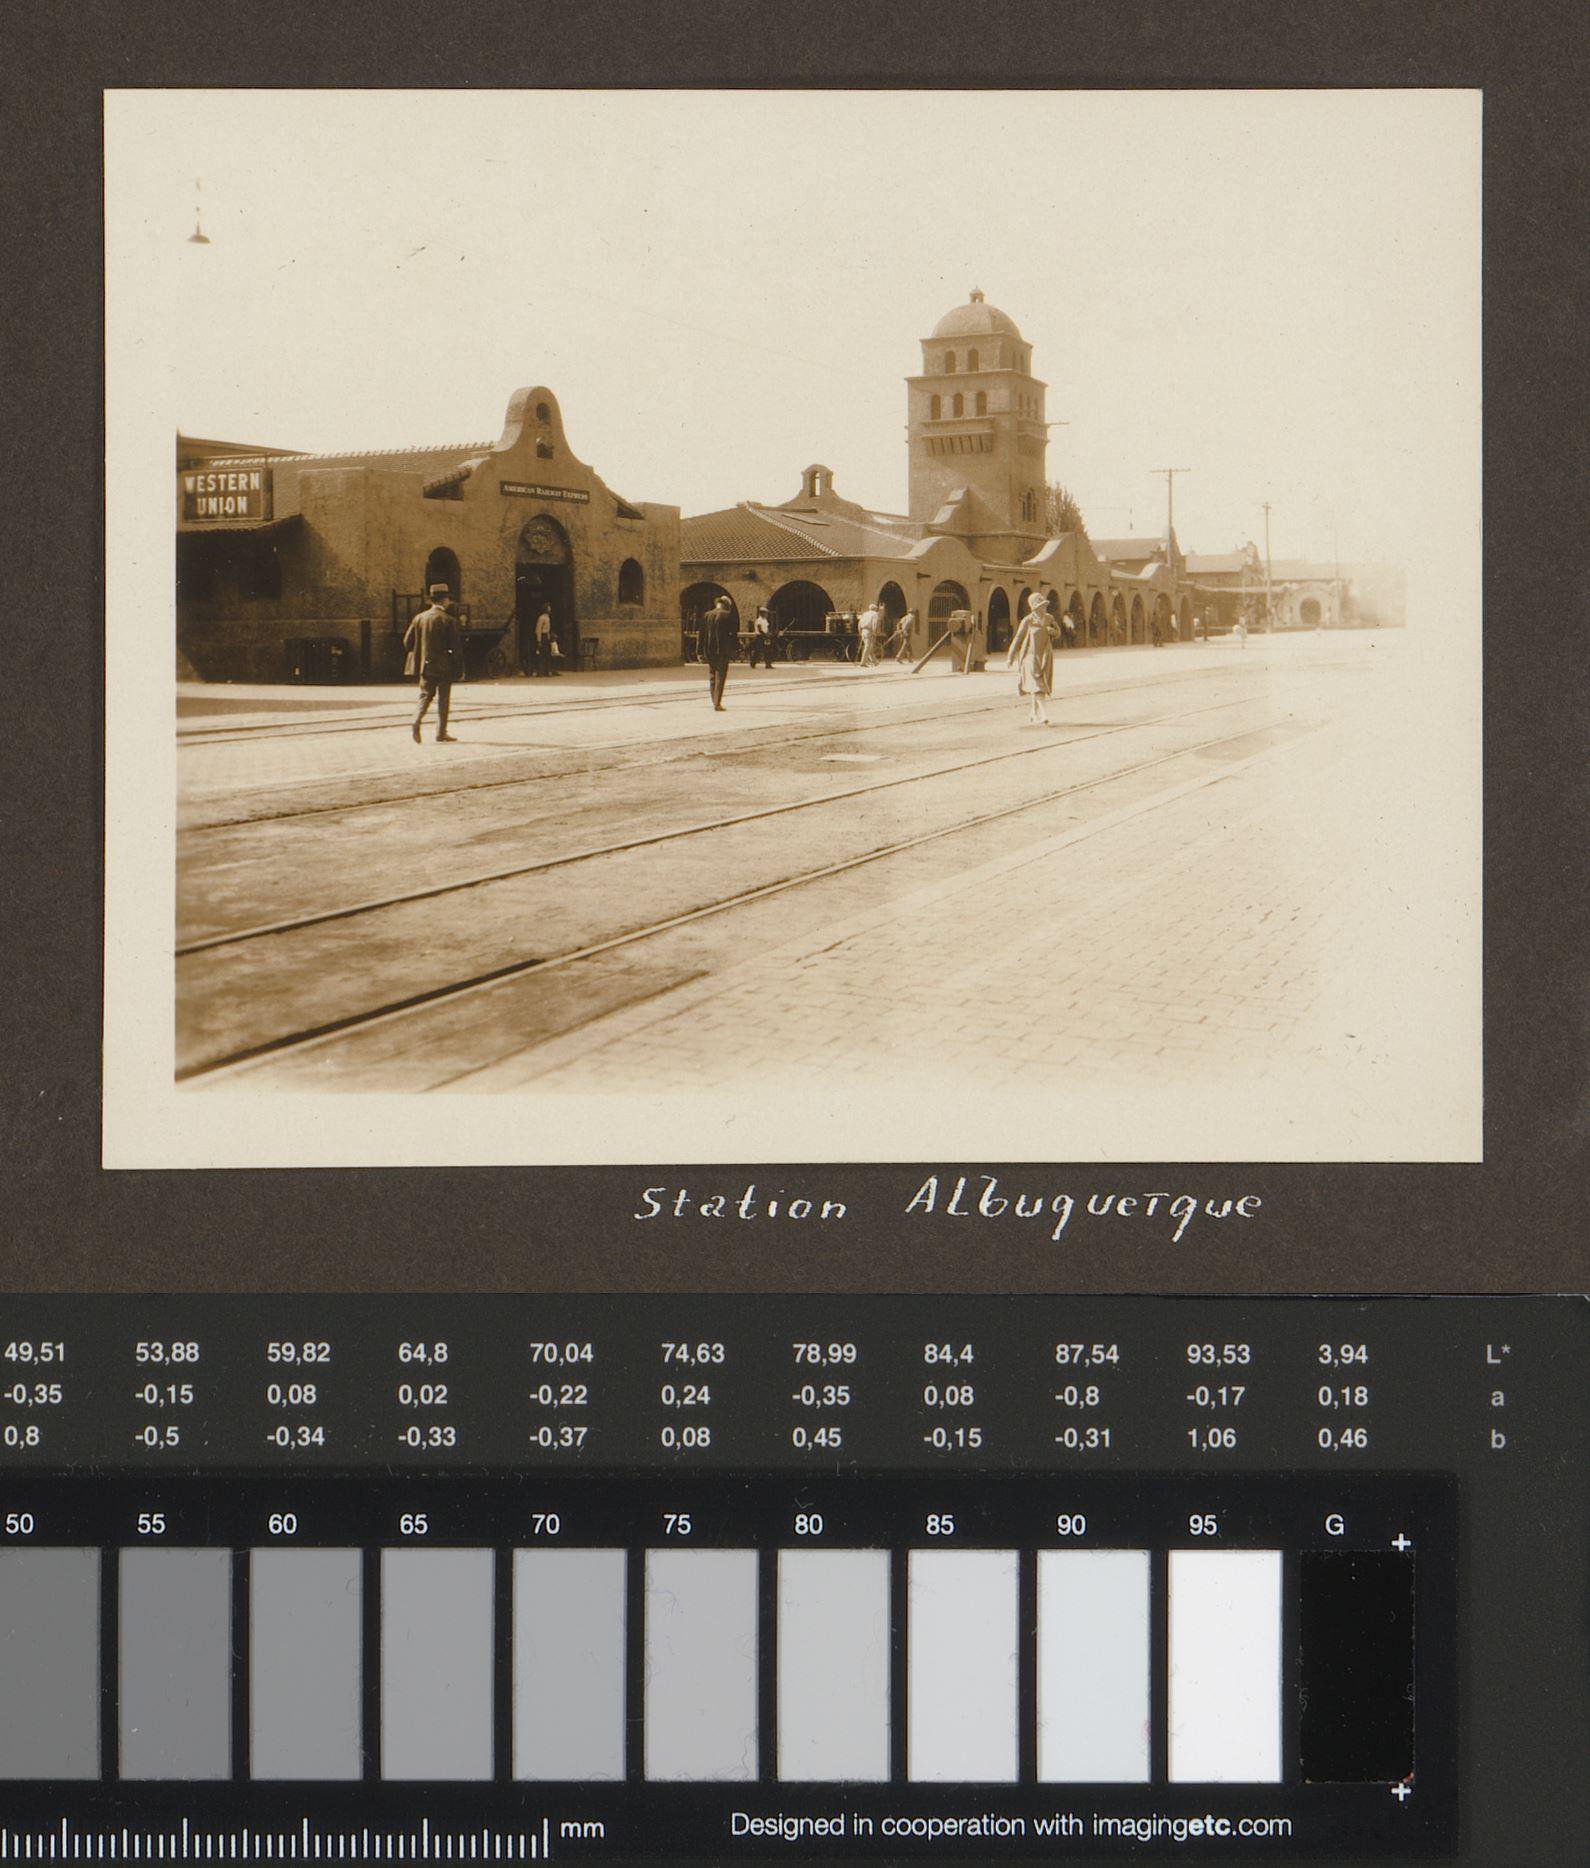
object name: photograph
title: Treinstation te Albuquerque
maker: Anonymous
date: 1928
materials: photographic support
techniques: gelatin silver print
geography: albuquerque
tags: station; shelter (railway, tramway)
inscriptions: annotation: ‘Station Albuquerque’